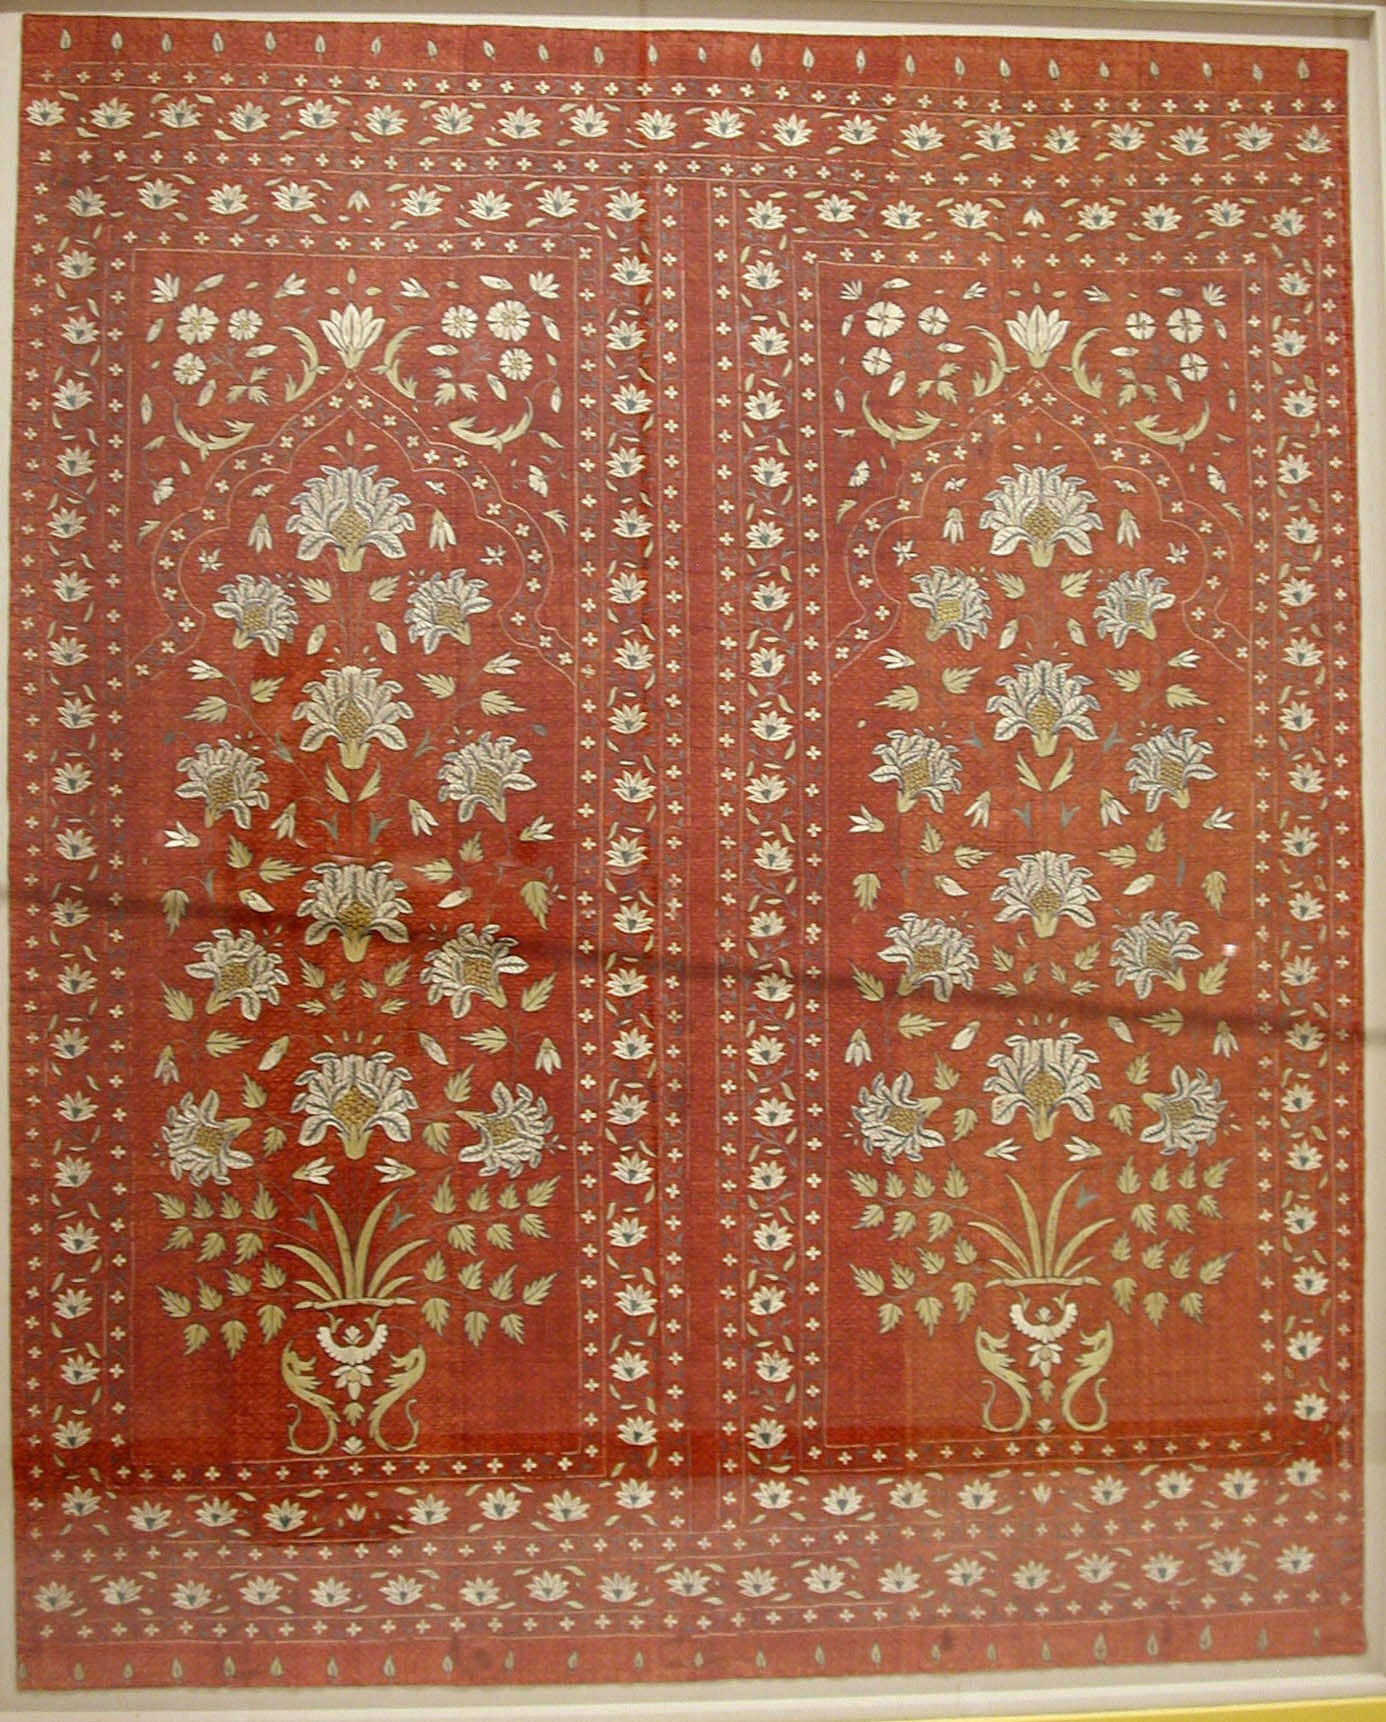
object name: textile fragment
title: Tent Lining Fragment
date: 1701-1800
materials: cotton, silk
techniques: embroidery, weave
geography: india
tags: flowers